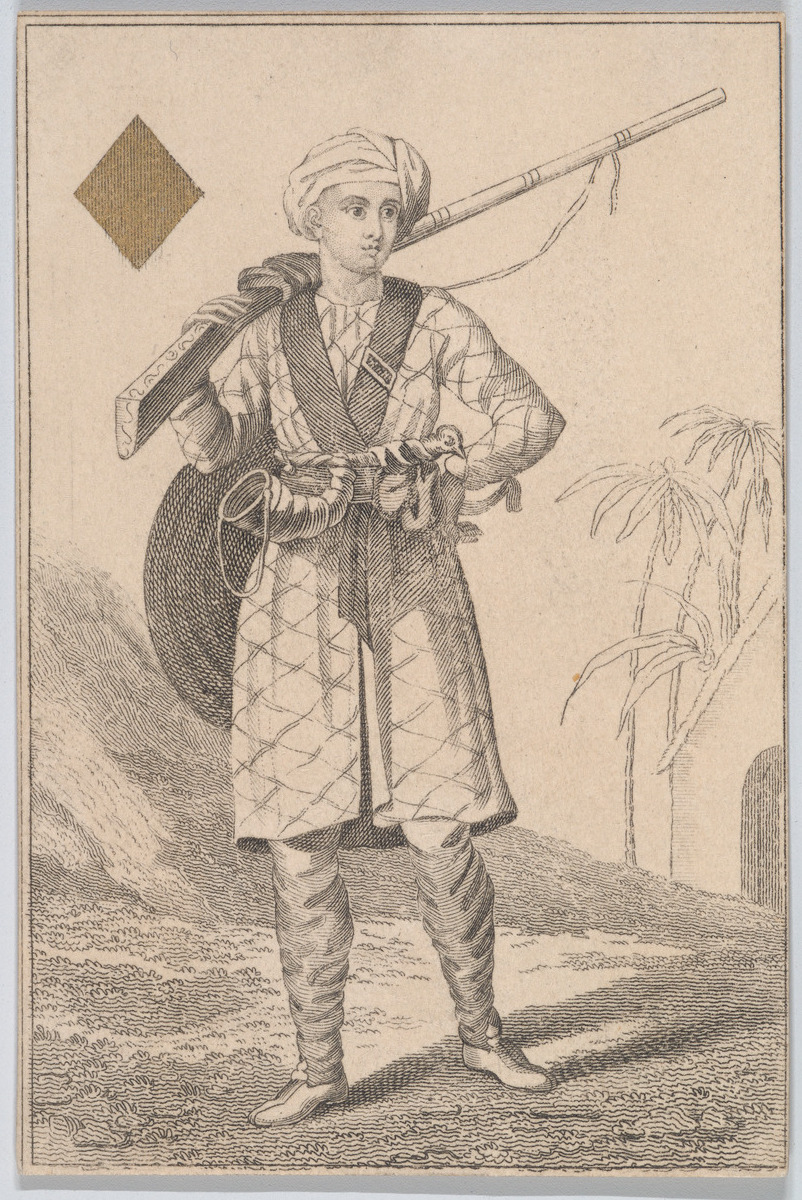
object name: print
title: Knave (Hyder Ali from Mysore), from "Court Game of Geography"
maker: william and henry rock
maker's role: publisher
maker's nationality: british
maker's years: 1821-1884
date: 1838-1855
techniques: engraving, etching, hand coloring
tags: men,playing cards